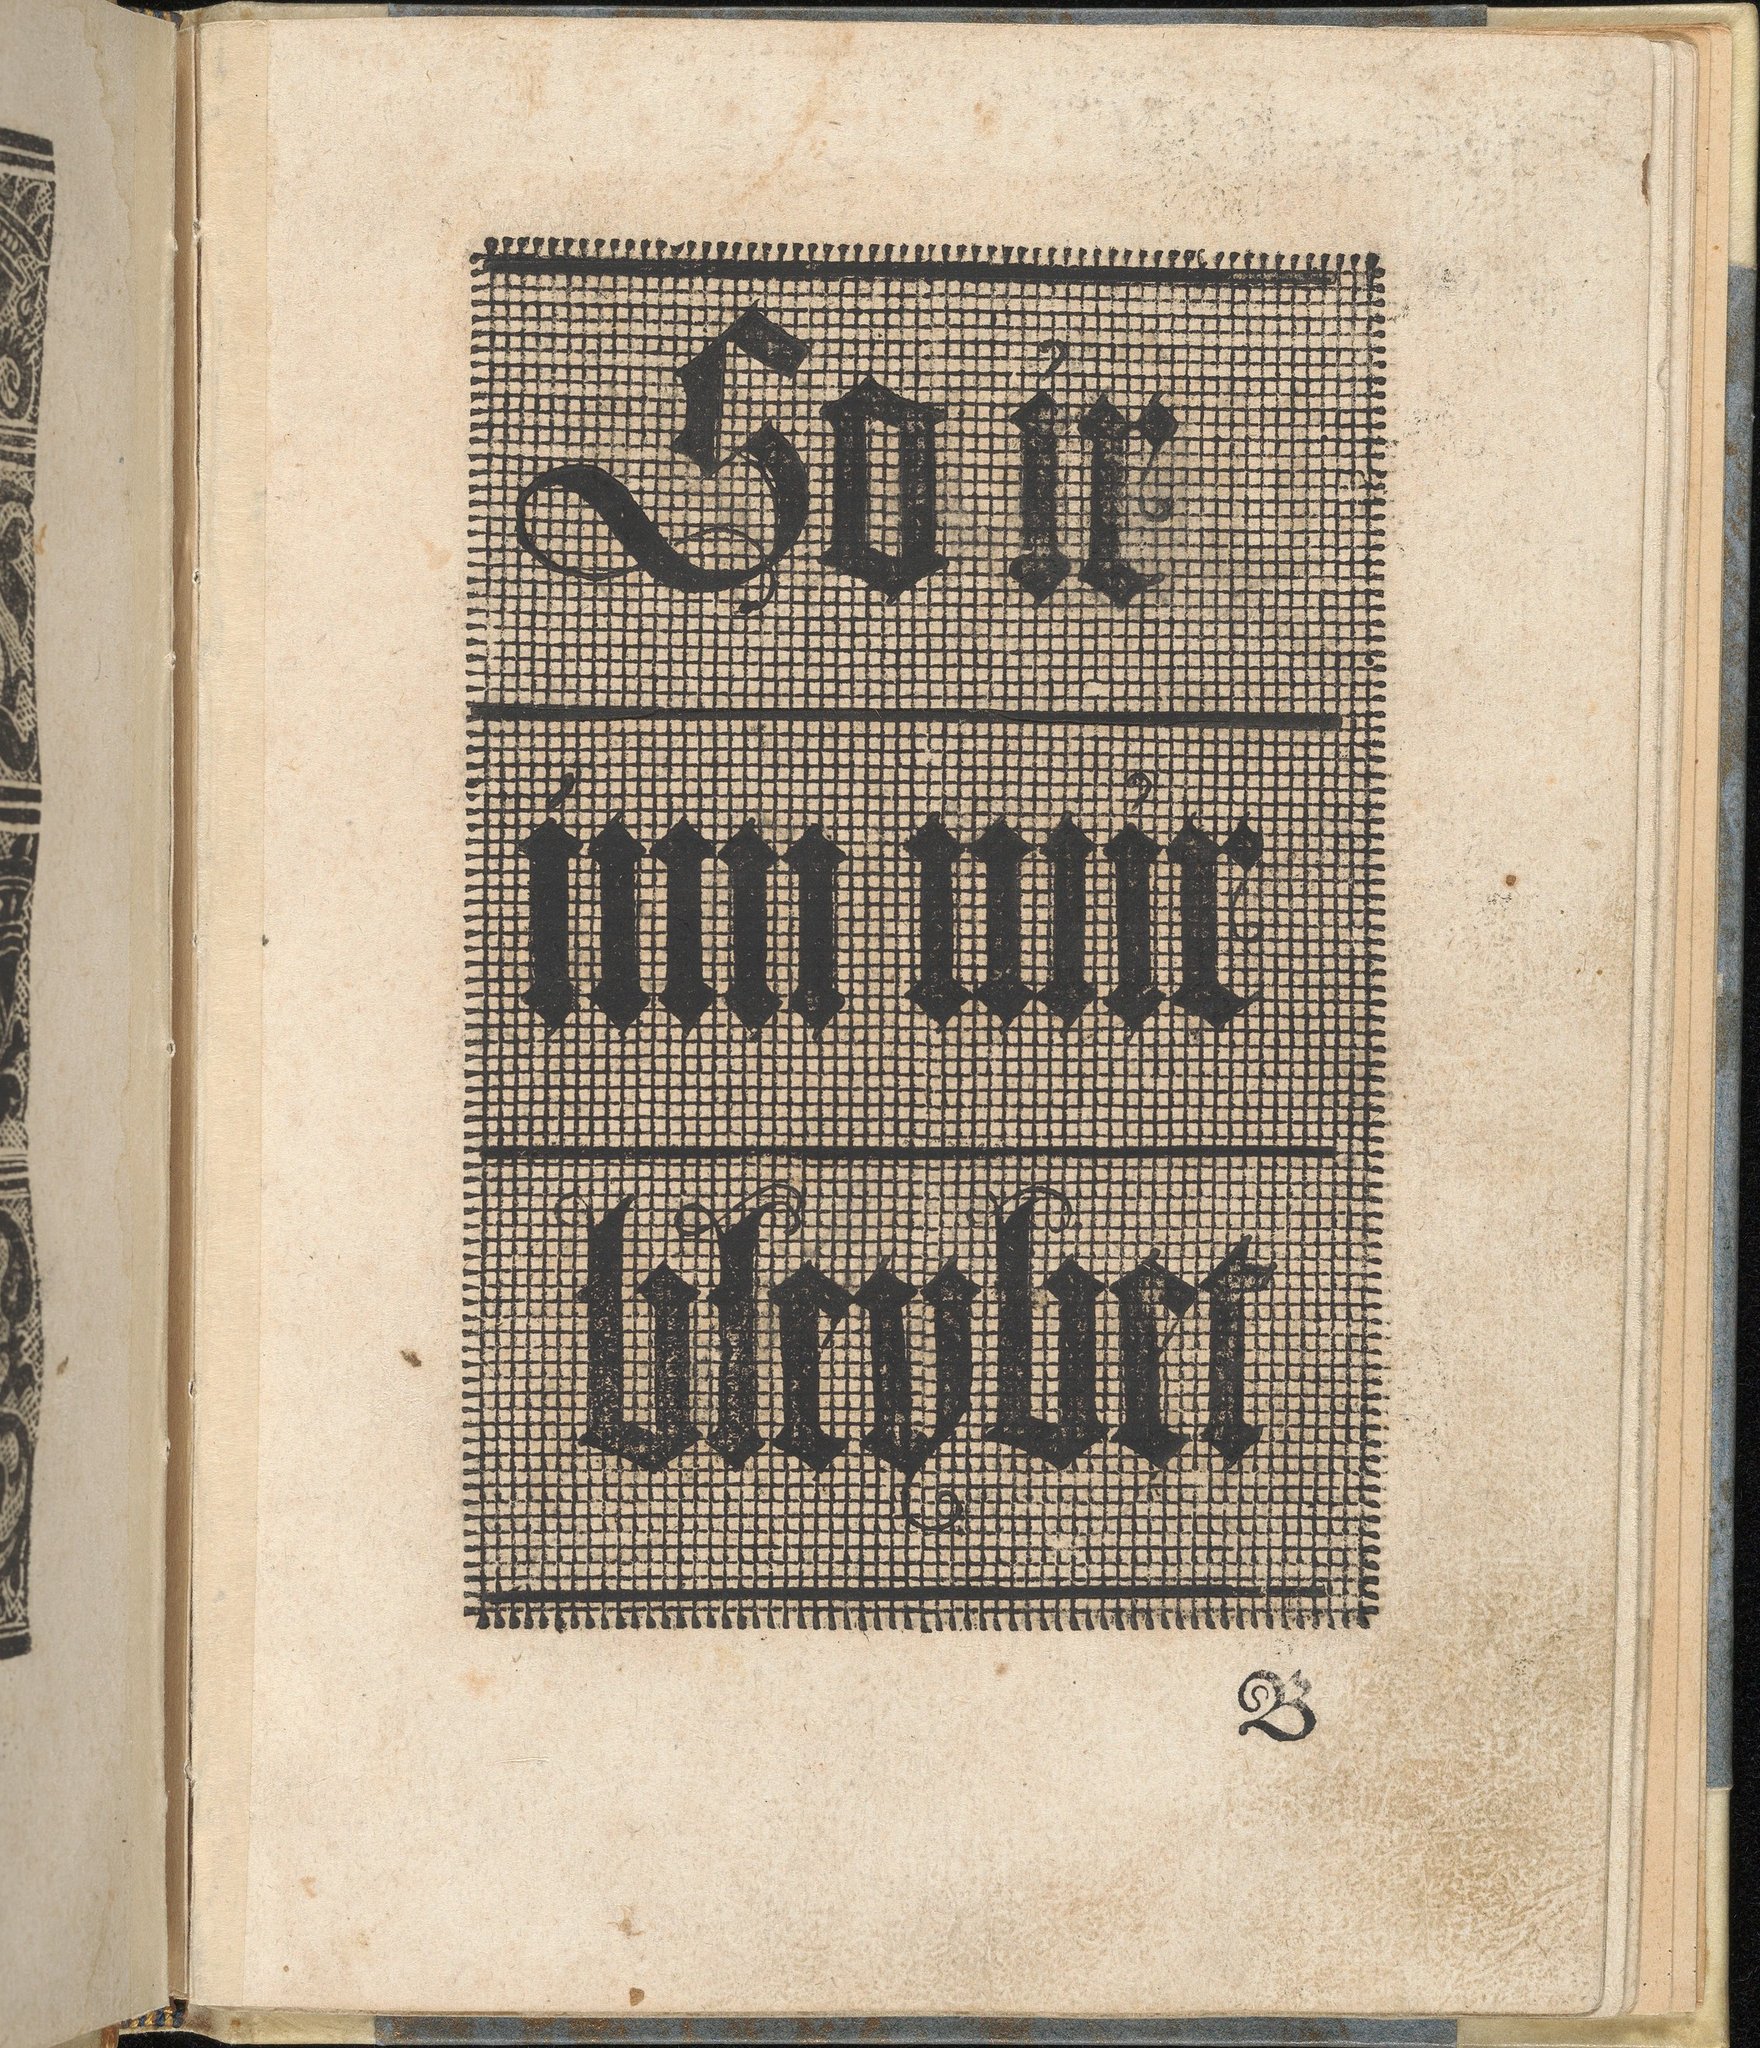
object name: book print ornament architecture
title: Ein ney Furmbüchlein, Page 3, recto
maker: johann schönsperger the younger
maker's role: publisher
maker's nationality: german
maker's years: 1490-1550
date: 1525-1529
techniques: woodcut